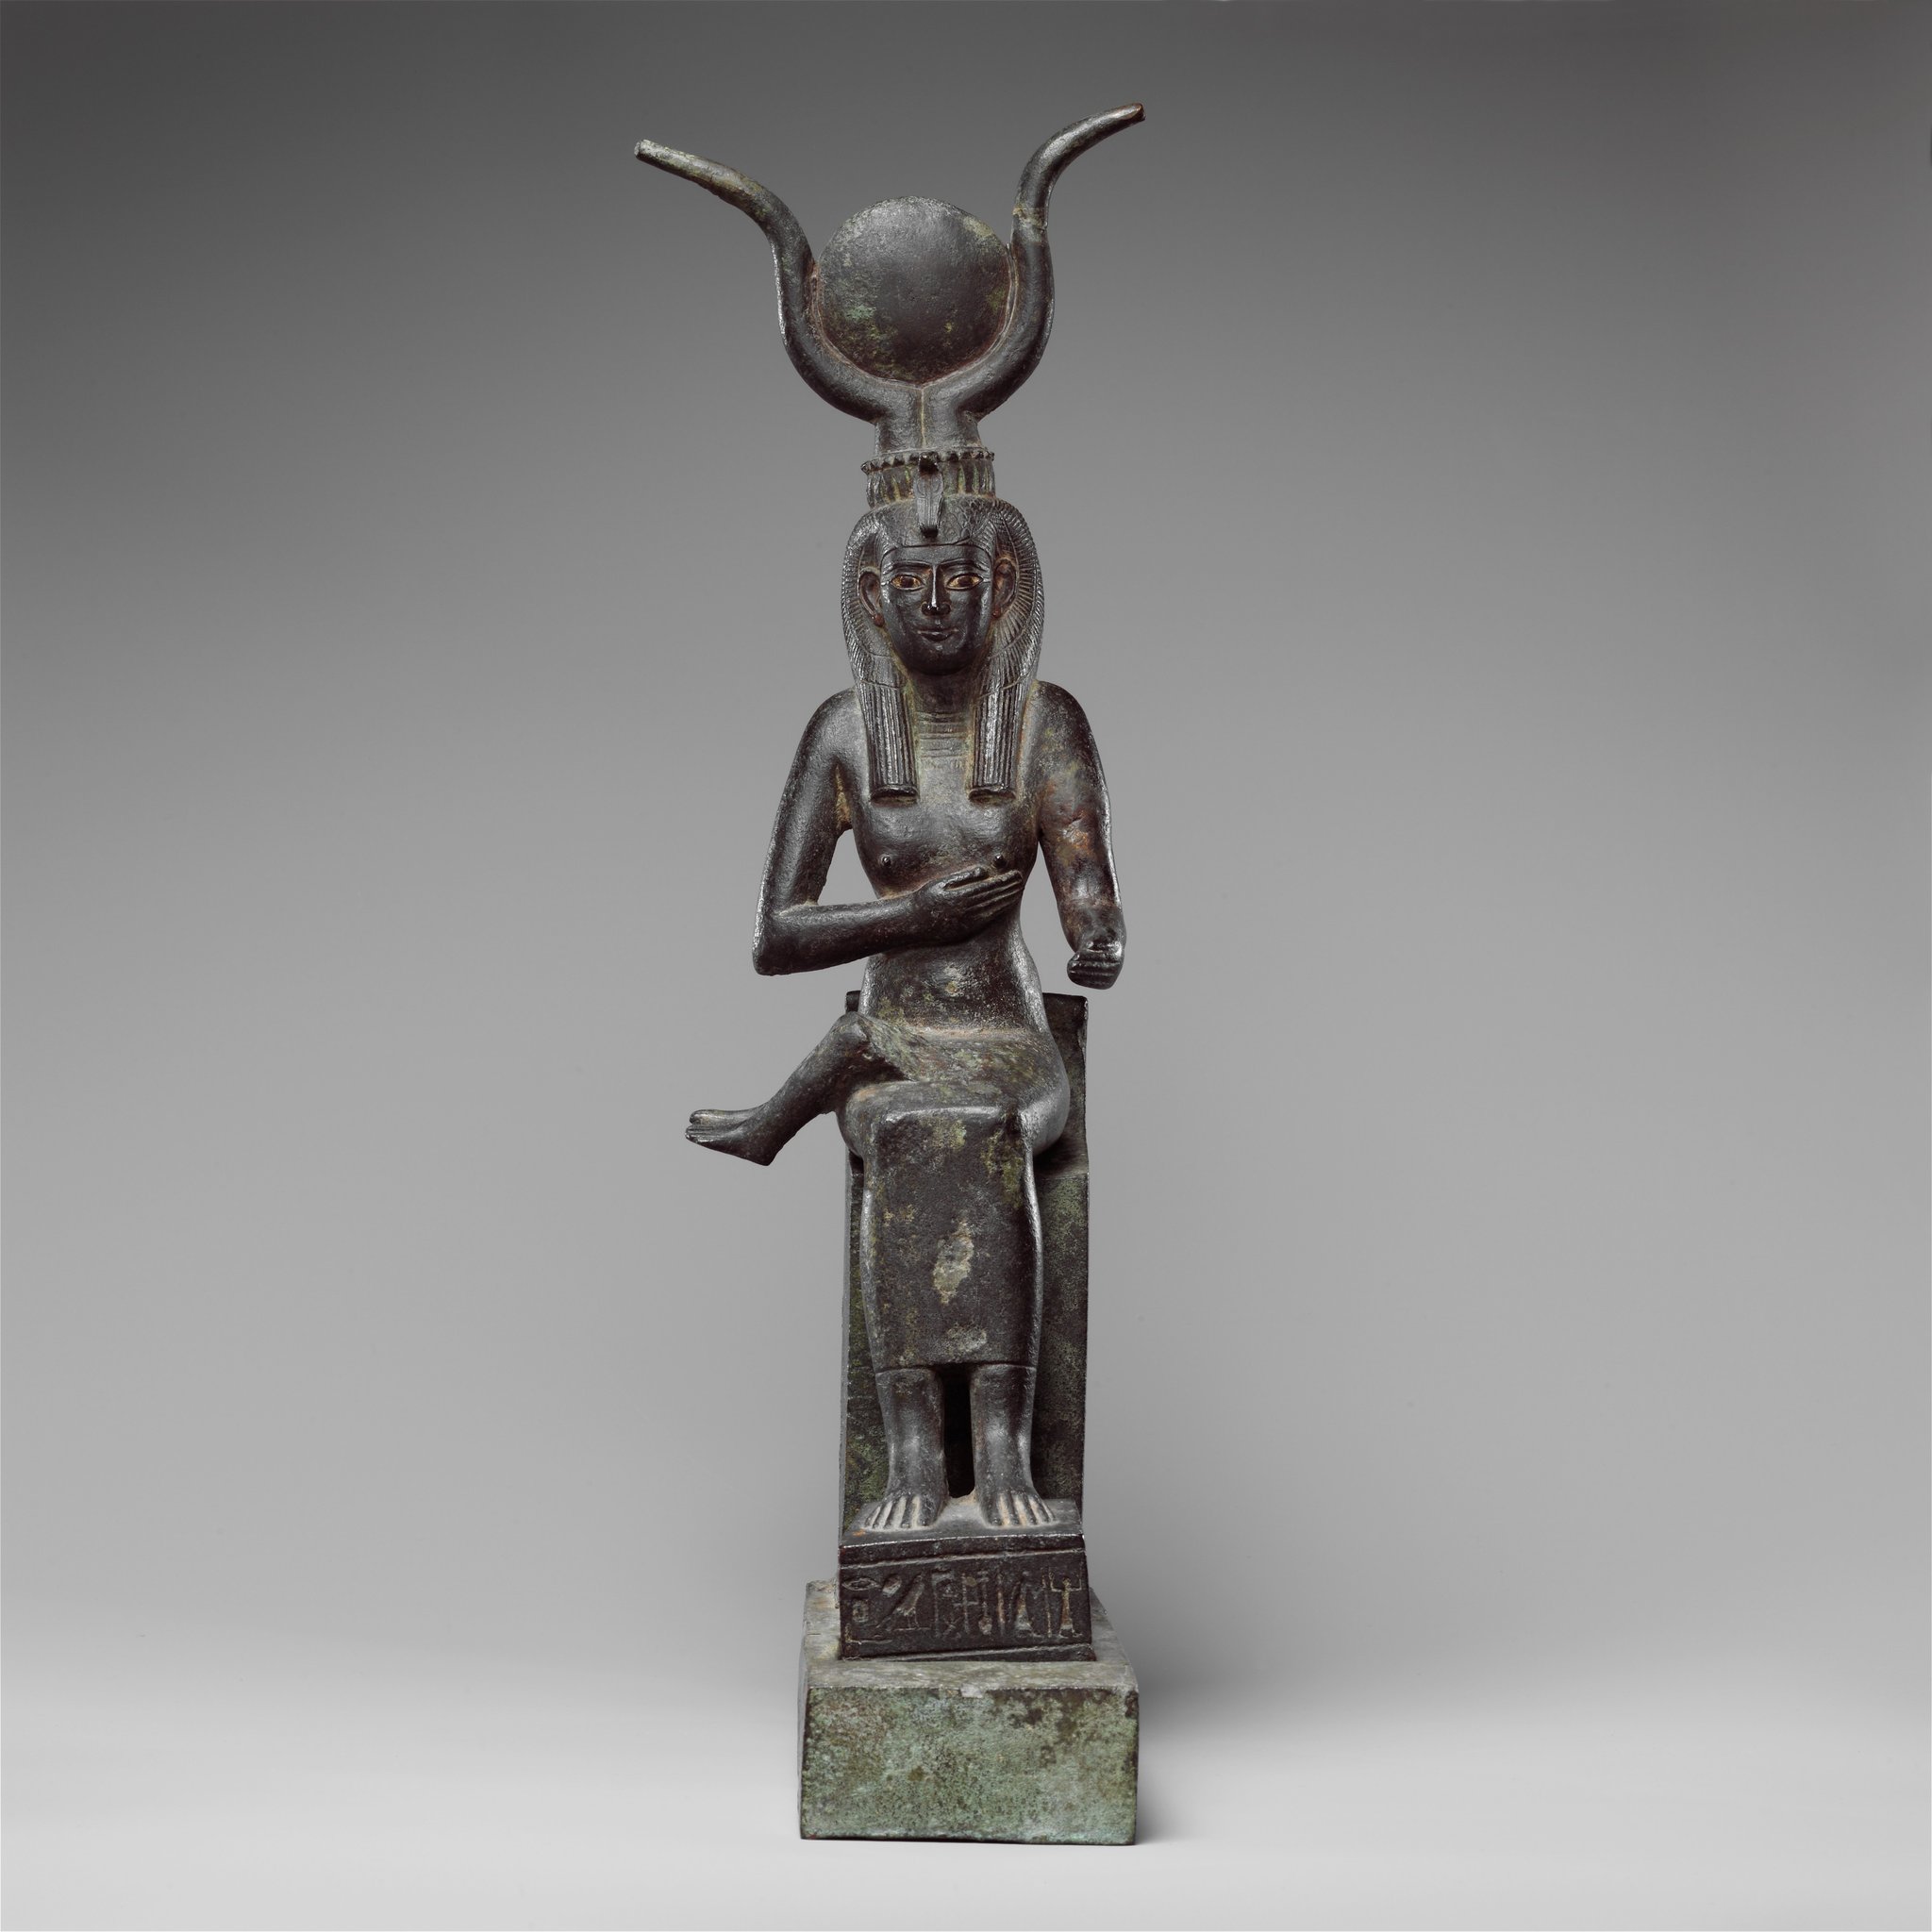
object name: statuette, isi, horus padihorresnet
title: Statuette of Isis nursing Horus (missing above the legs), inscribed for Hor son of Padihorresnet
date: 611-594 BCE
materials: bronze, gilt silver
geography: egypt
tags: horus,isis,nursing